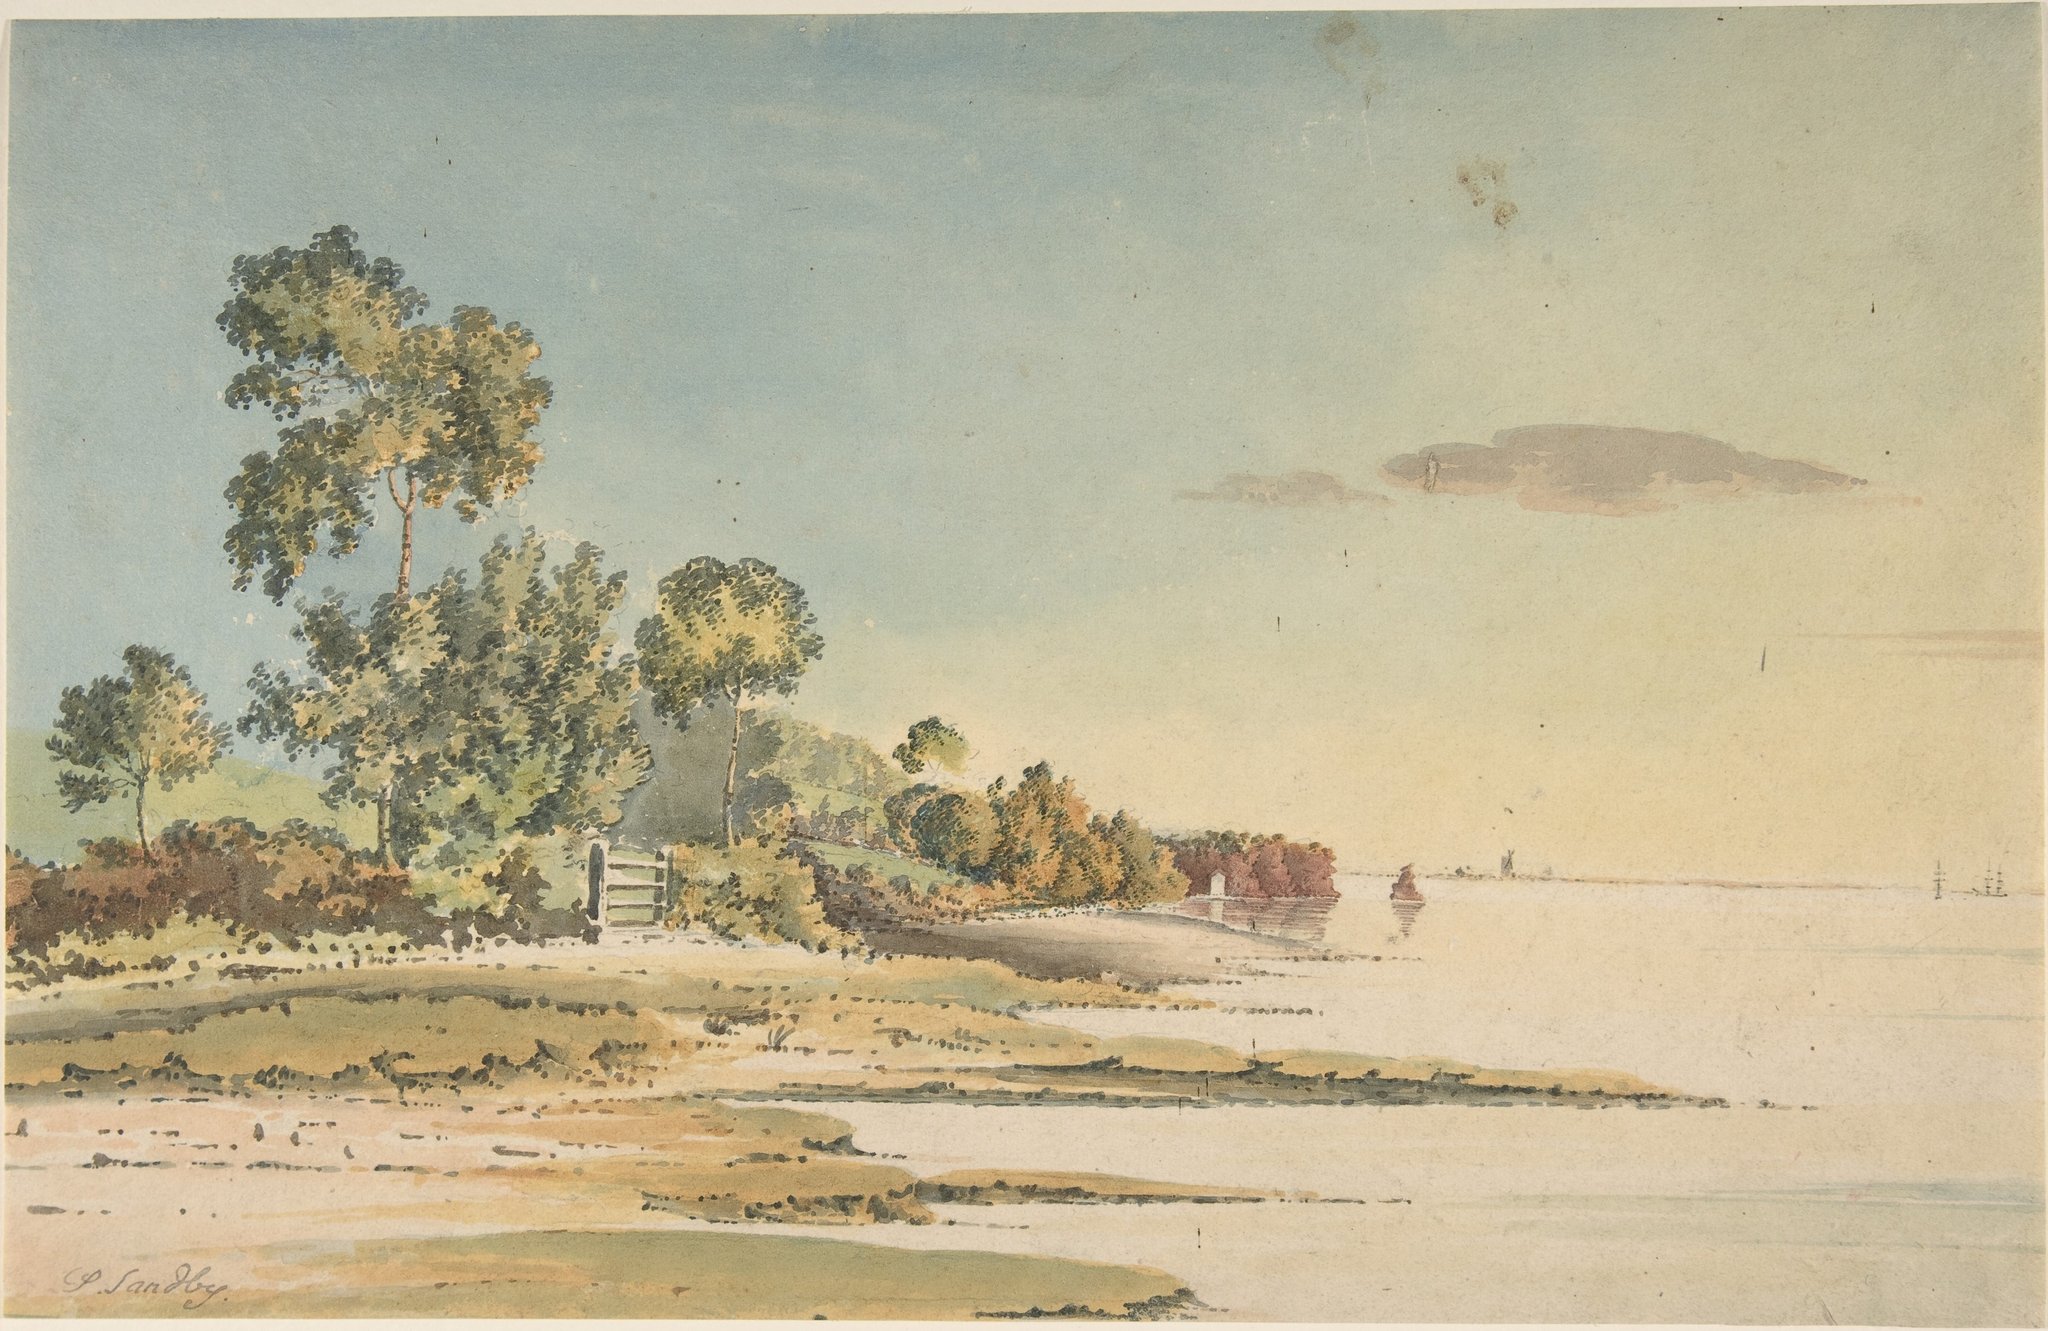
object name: drawing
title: Landscape on a Bay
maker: anonymous, british, 19th century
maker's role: artist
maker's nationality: british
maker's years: 1800-1900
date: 1801-1900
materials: watercolor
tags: landscapes